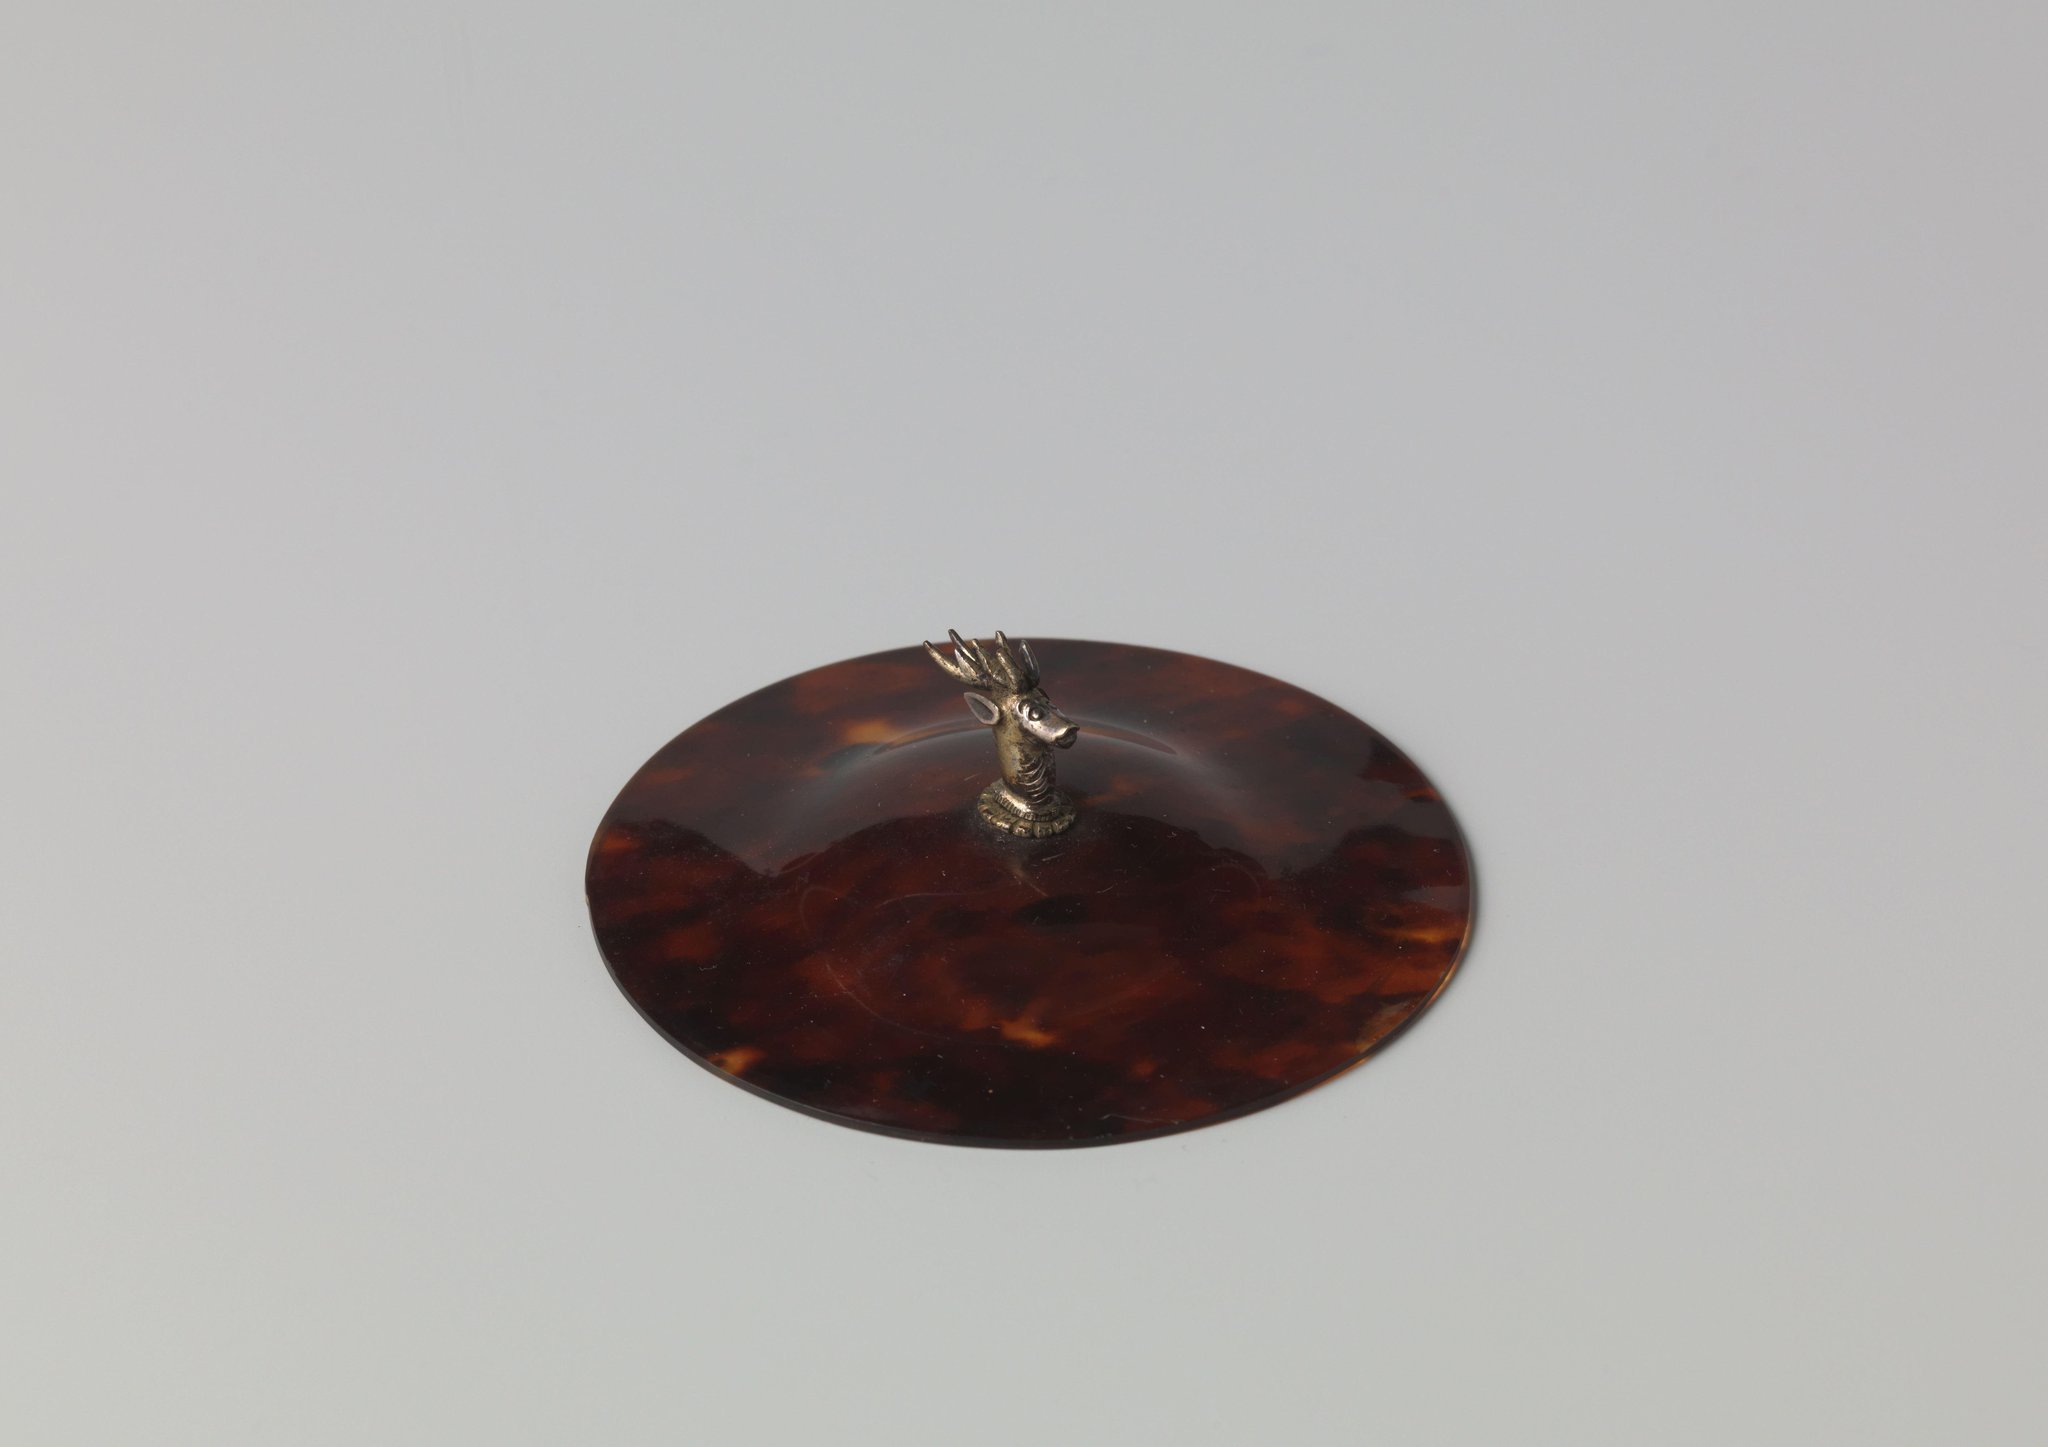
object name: schildpaddeksel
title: Deksel van schildpad met hertekop van zilver (serie van 28 stuks A t/m BB)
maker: Anonymous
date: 1700-1799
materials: silver, shell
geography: indonesia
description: Schildpad-deksel (28 stuks: A t/m BB) met hertekop van zilver als knop.